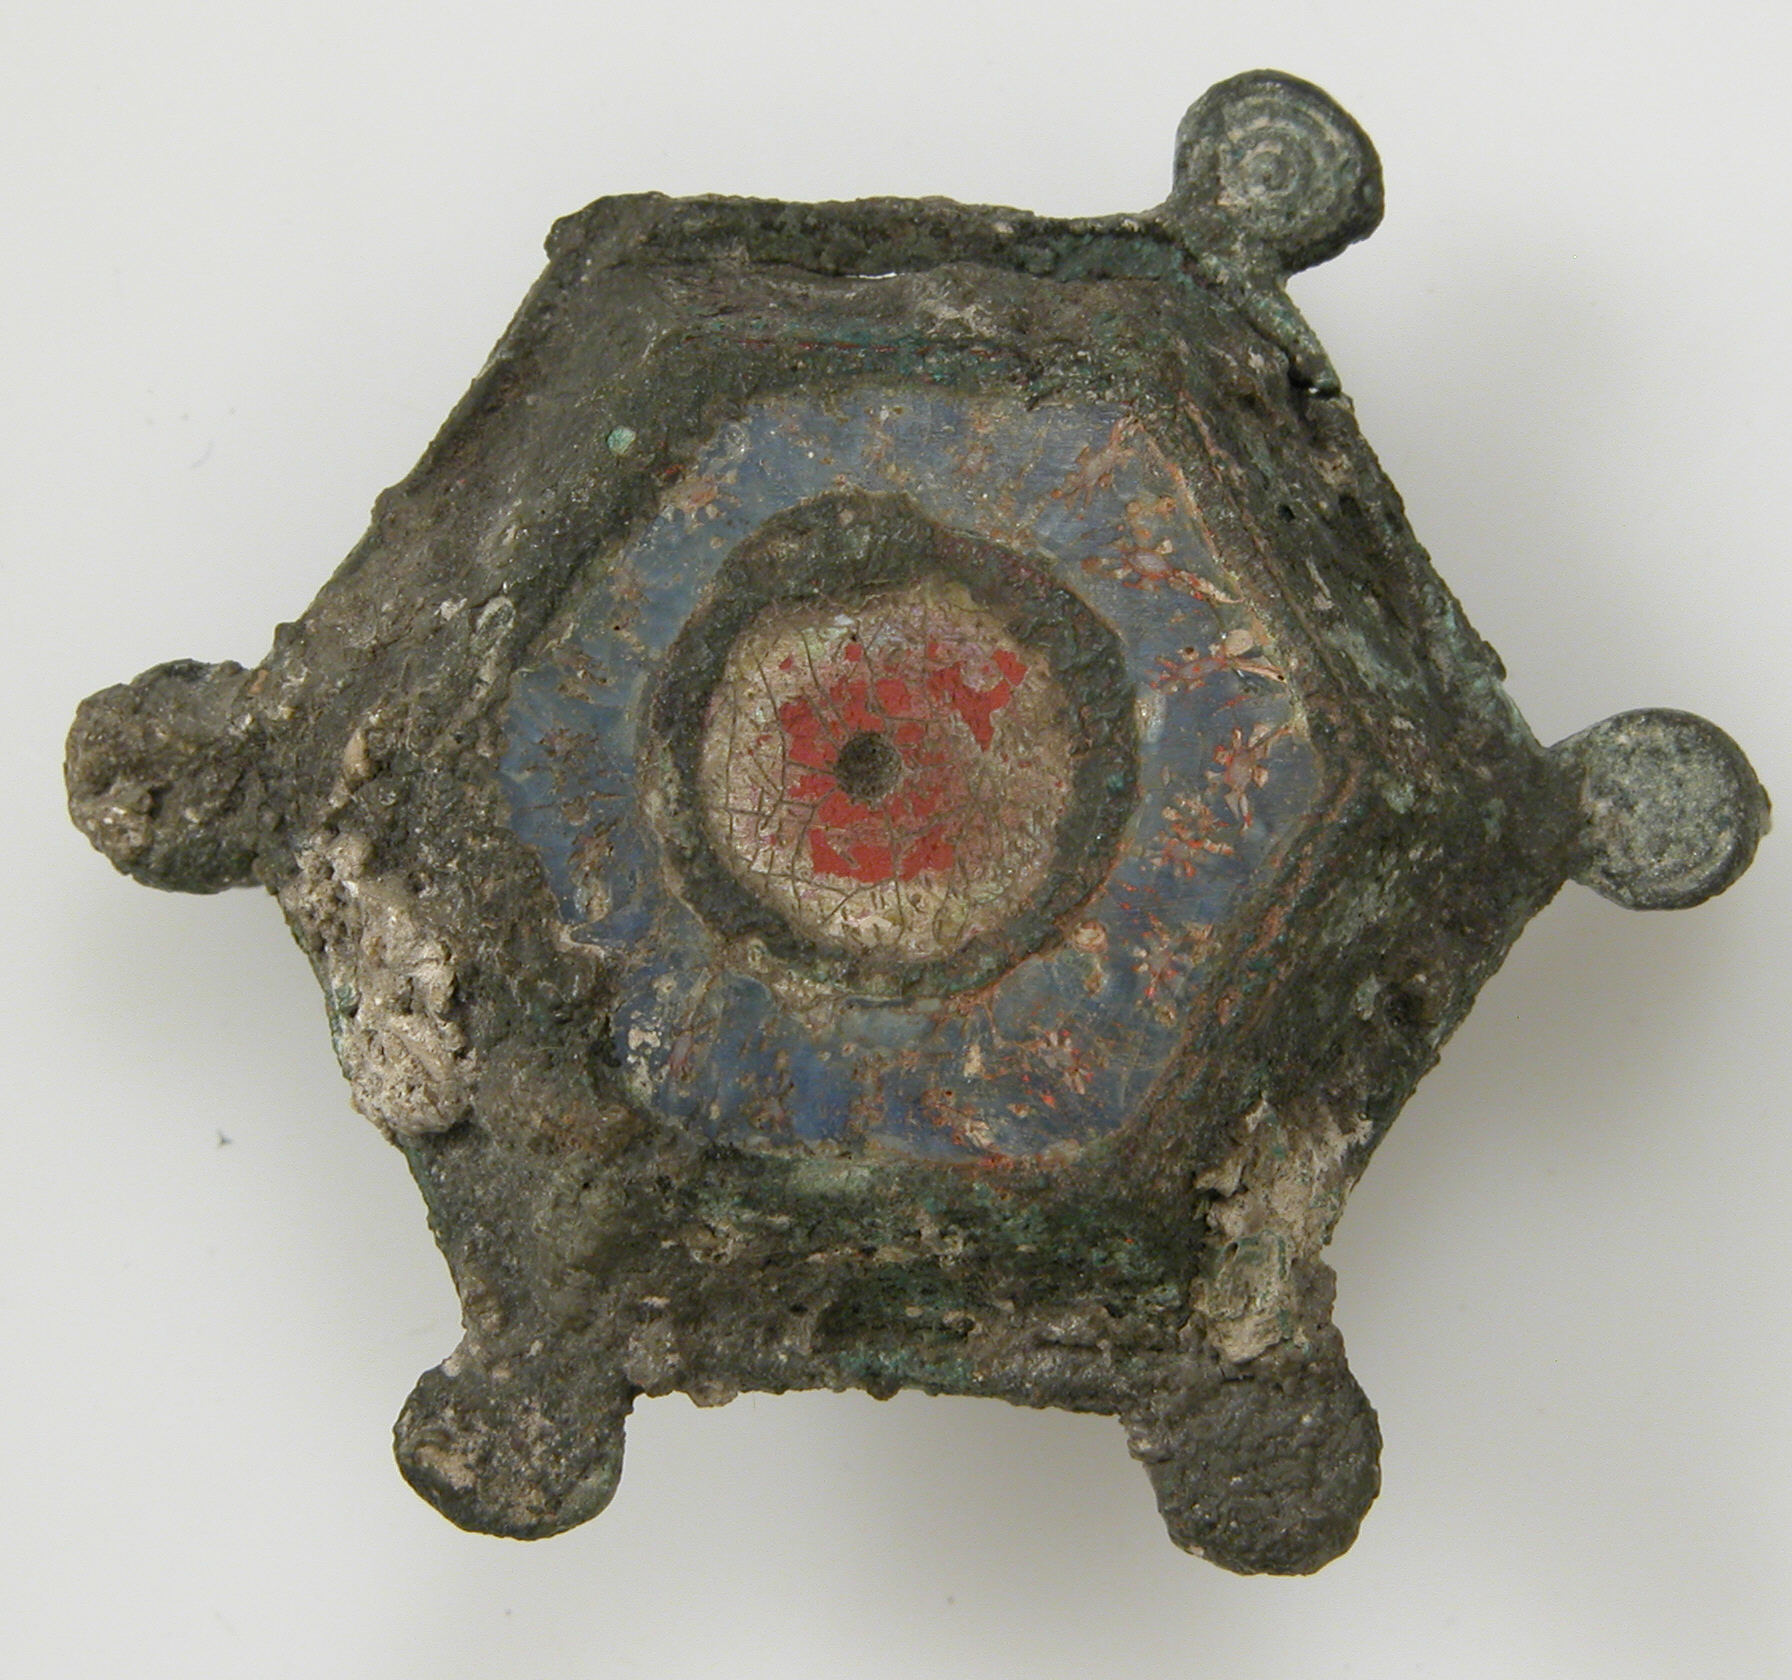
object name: pin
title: Hexagonal Pin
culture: roman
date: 100-300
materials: bronze, enamel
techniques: enamel